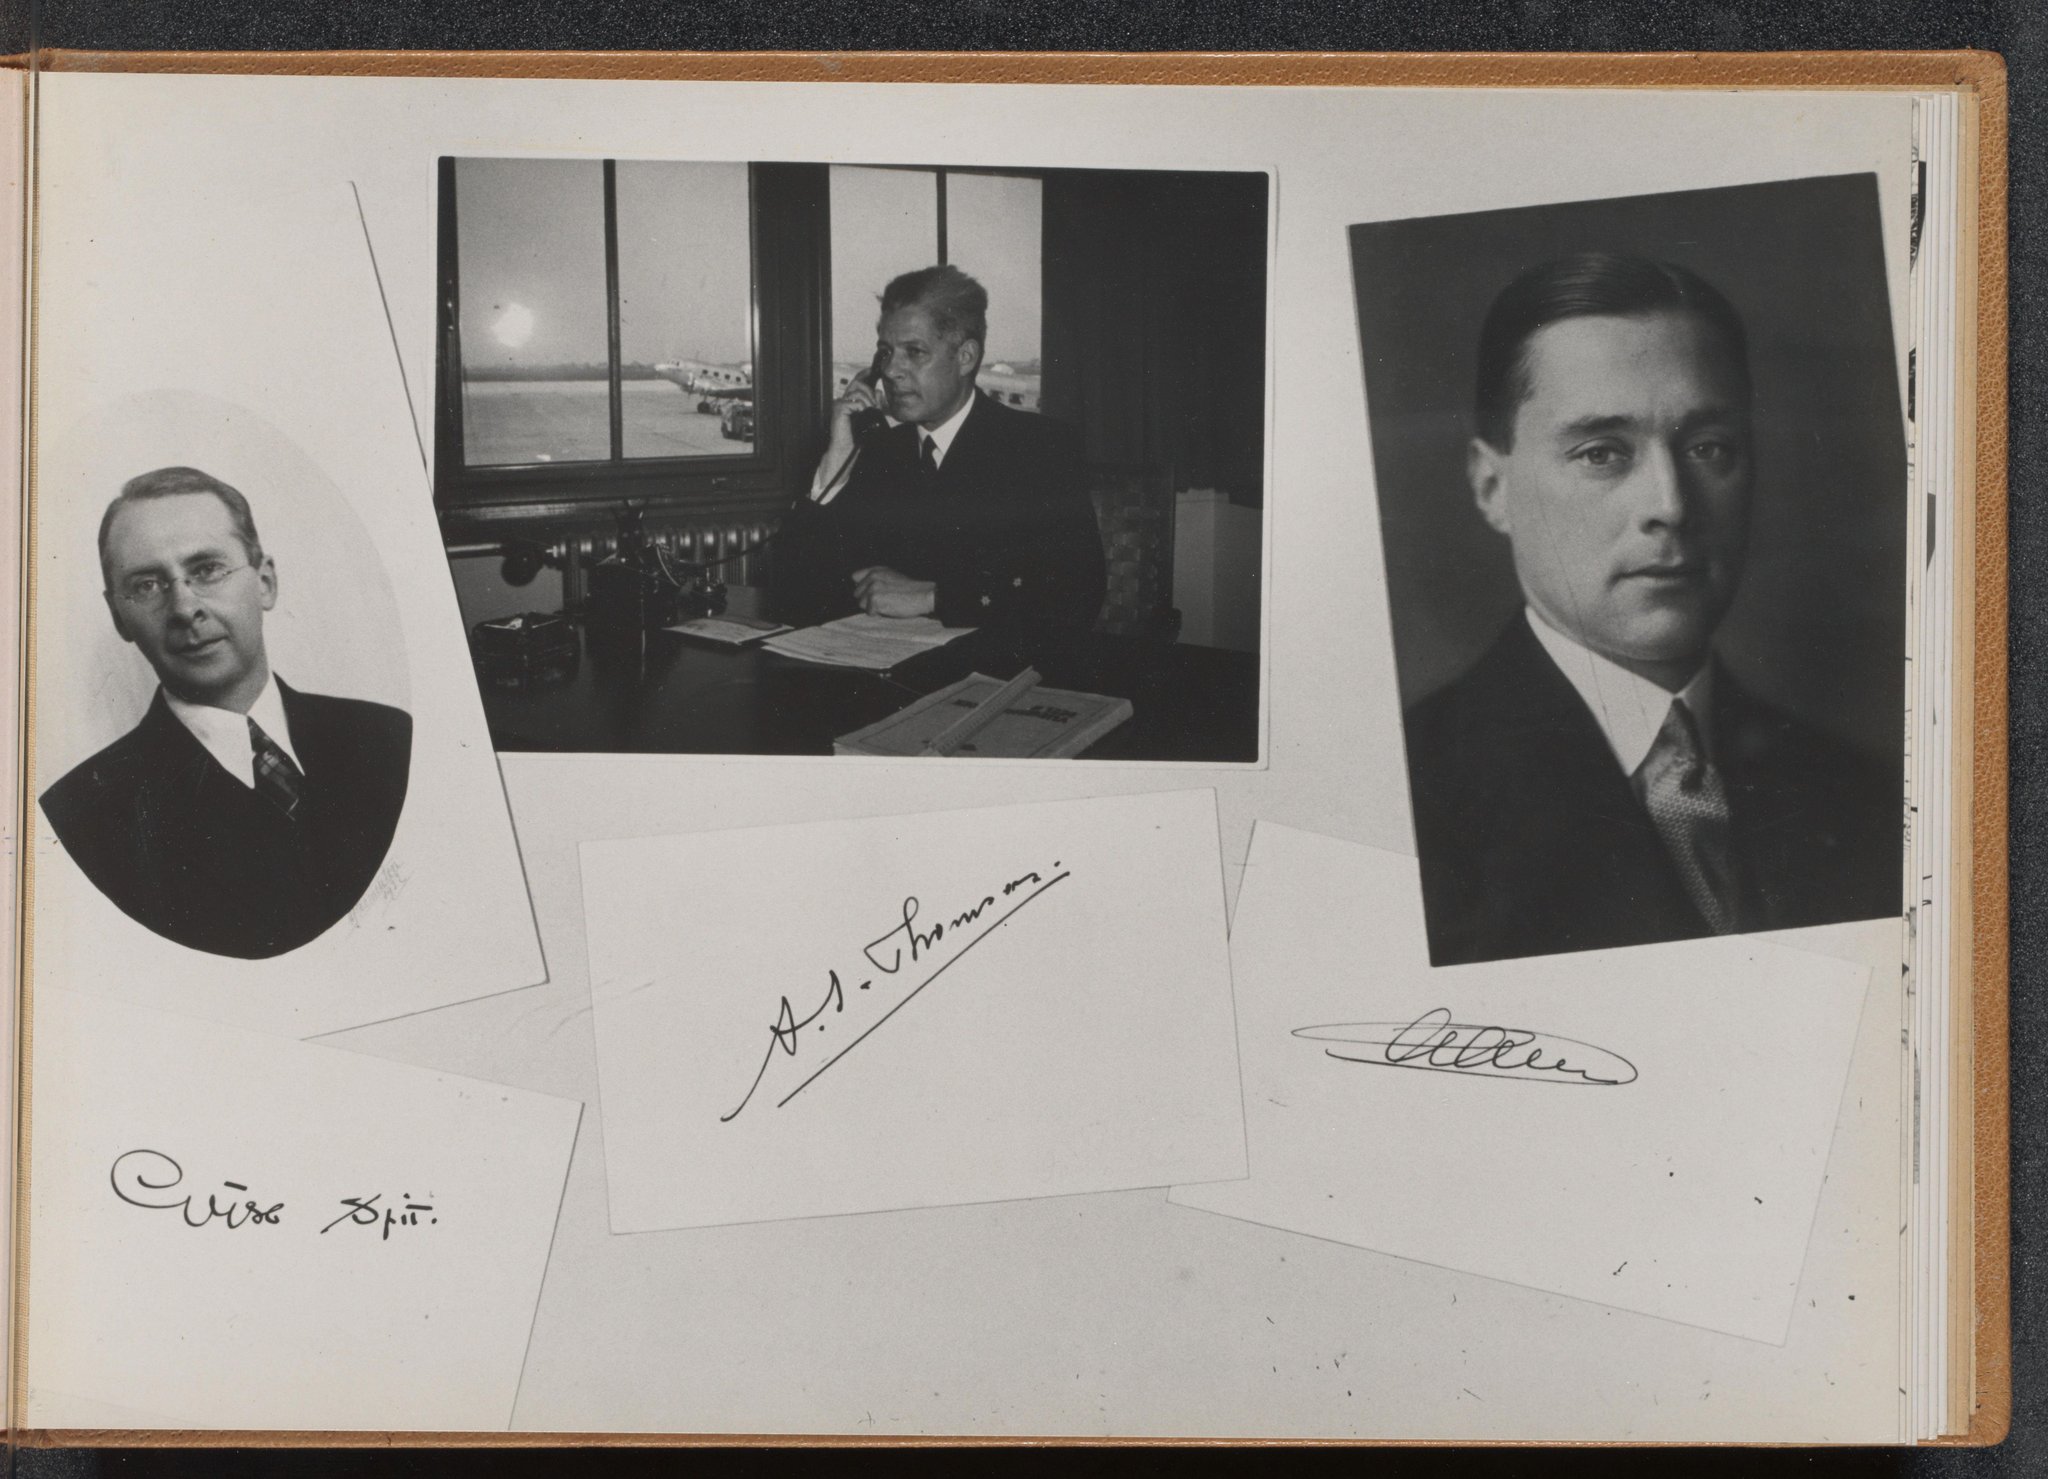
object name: photograph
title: KLM-personeel en handtekeningen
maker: Anonymous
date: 1949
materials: cardboard, paper, photographic support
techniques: gelatin silver print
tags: airborne traffic, aviation, director, boss (in modern industry), travelling; tourism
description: Albumblad met een compositiefoto van drie KLM-medewerkers, waaronder links Gijs Spit, en hun handtekeningen. Onderdeel van Herdenkingsalbum van de Indië-lijn van de KLM, deel II.